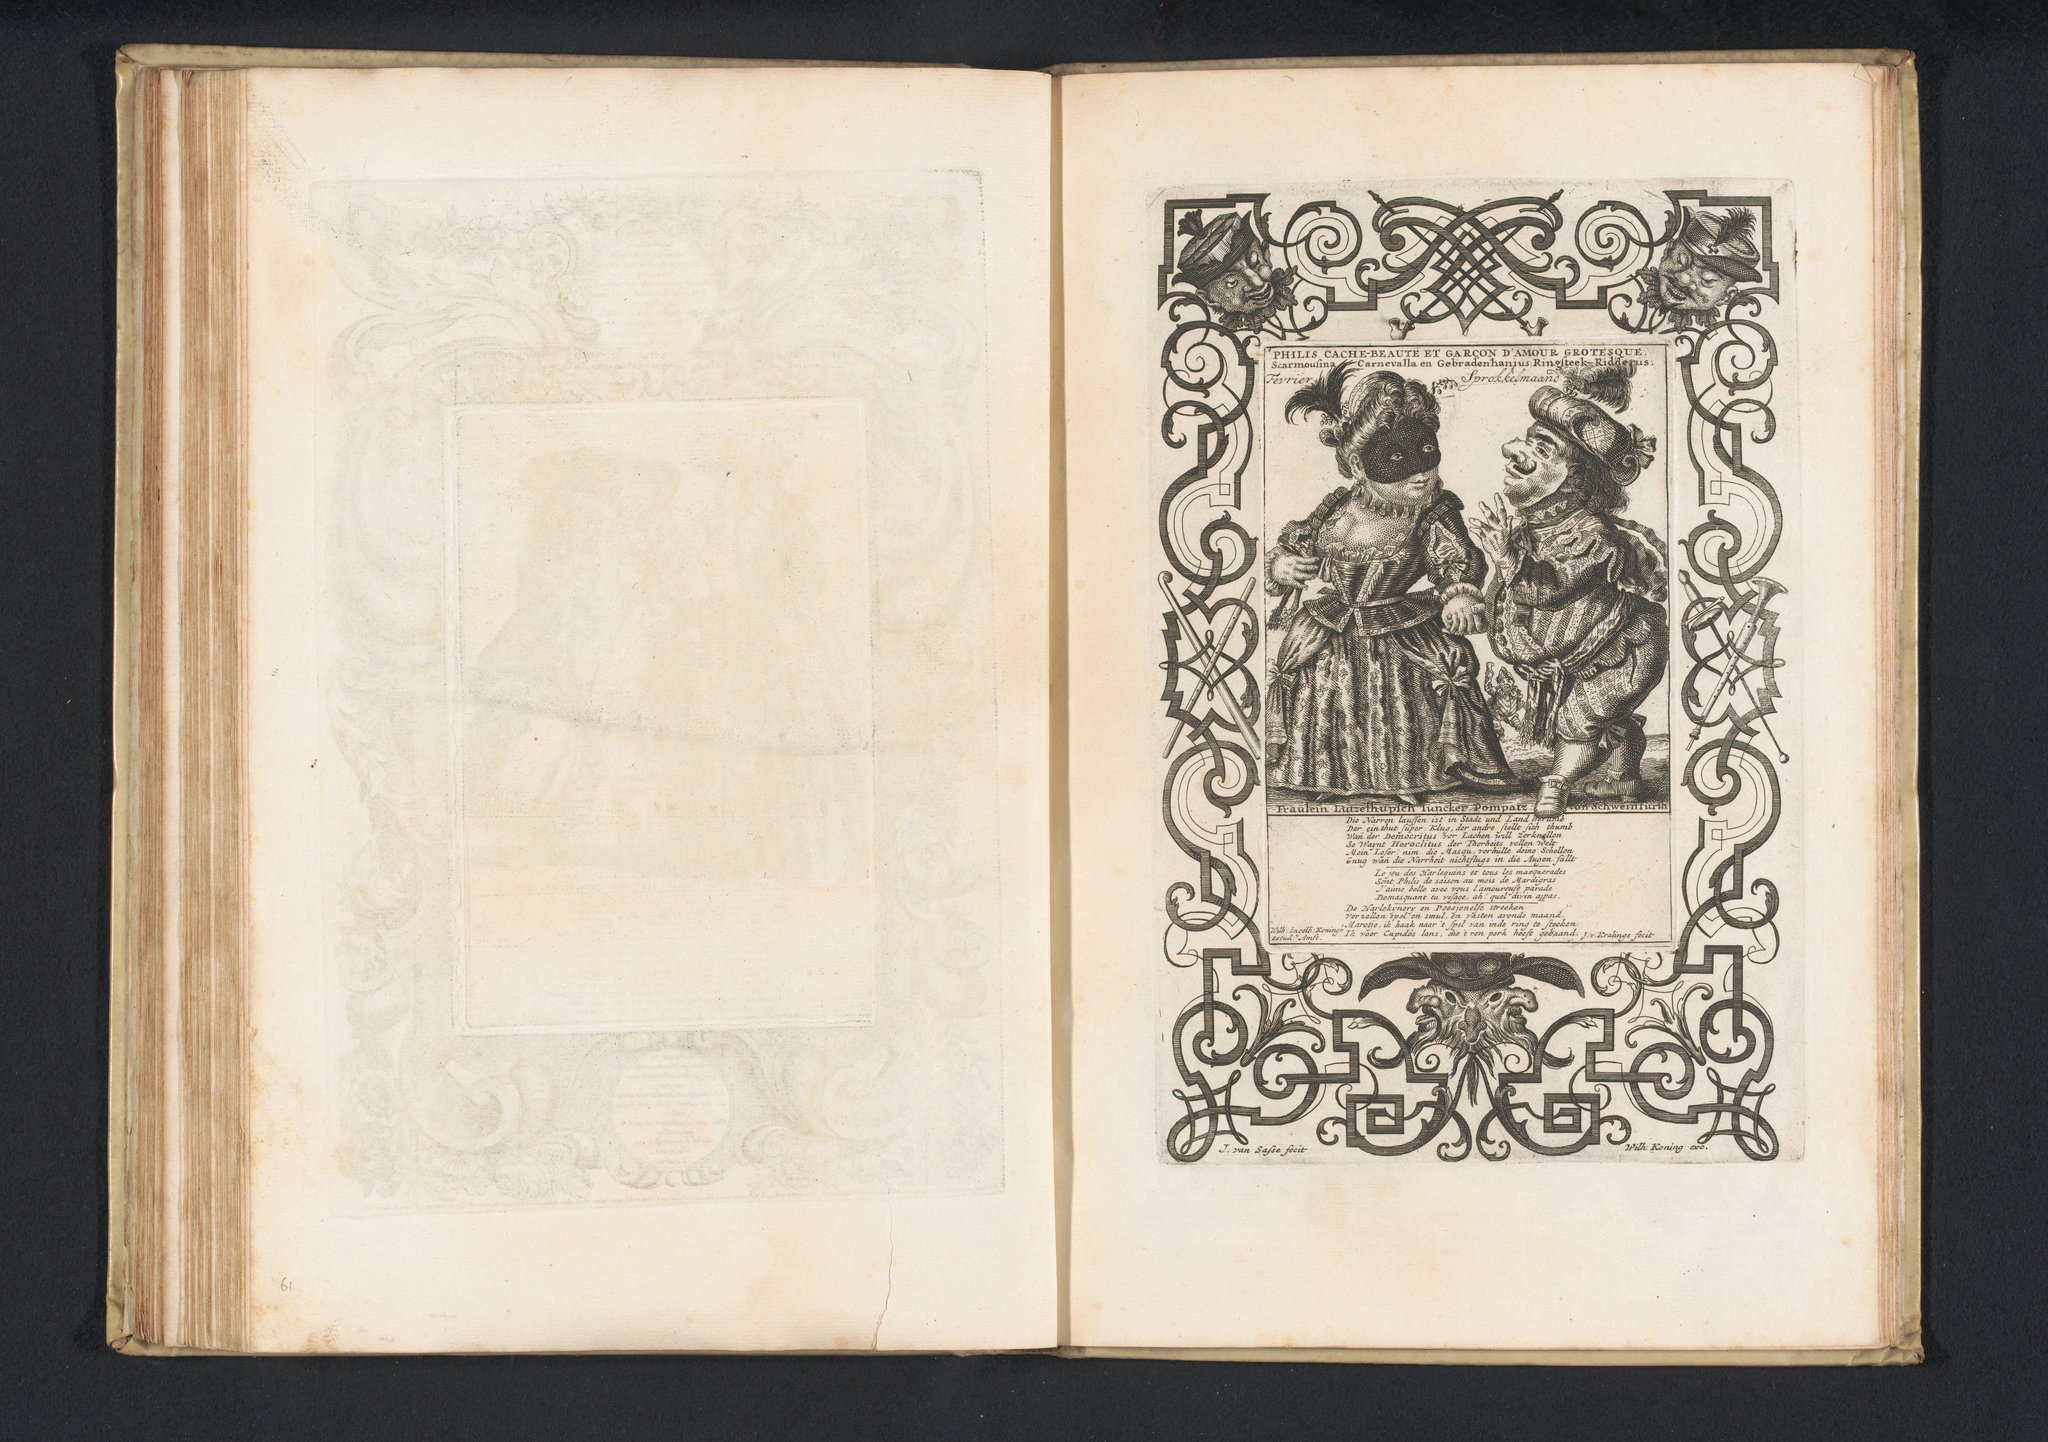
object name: caricature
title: Twee kleine mensen voor de maand februari, 1720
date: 1716-1720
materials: paper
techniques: engraving, etching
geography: amsterdam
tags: caricatures (human types), little people, february and its 'labours', masquerade, masked ball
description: Twee kleine mensen voor de maand februari (Sprokkelmaand). Gemaskerd paar op een carnavalsfeest. In het onderschrift verzen in het Duits, Frans en Nederlands. Afdruk binnen een decoratieve omlijsting gedrukt van een aparte plaat met koppen van Chinese kleine mensen en maskers. Onderdeel van deel III (een serie van de twaalf maanden) in de tweede Nederlandse gebonden uitgave uit 1720 (en gerelateerd aan de Windhandel in dat jaar) van een serie karikaturen van kleine mensen, bekend als Het Dwergentooneel, deels gekopieerd naar een ouder Duits voorbeeld.